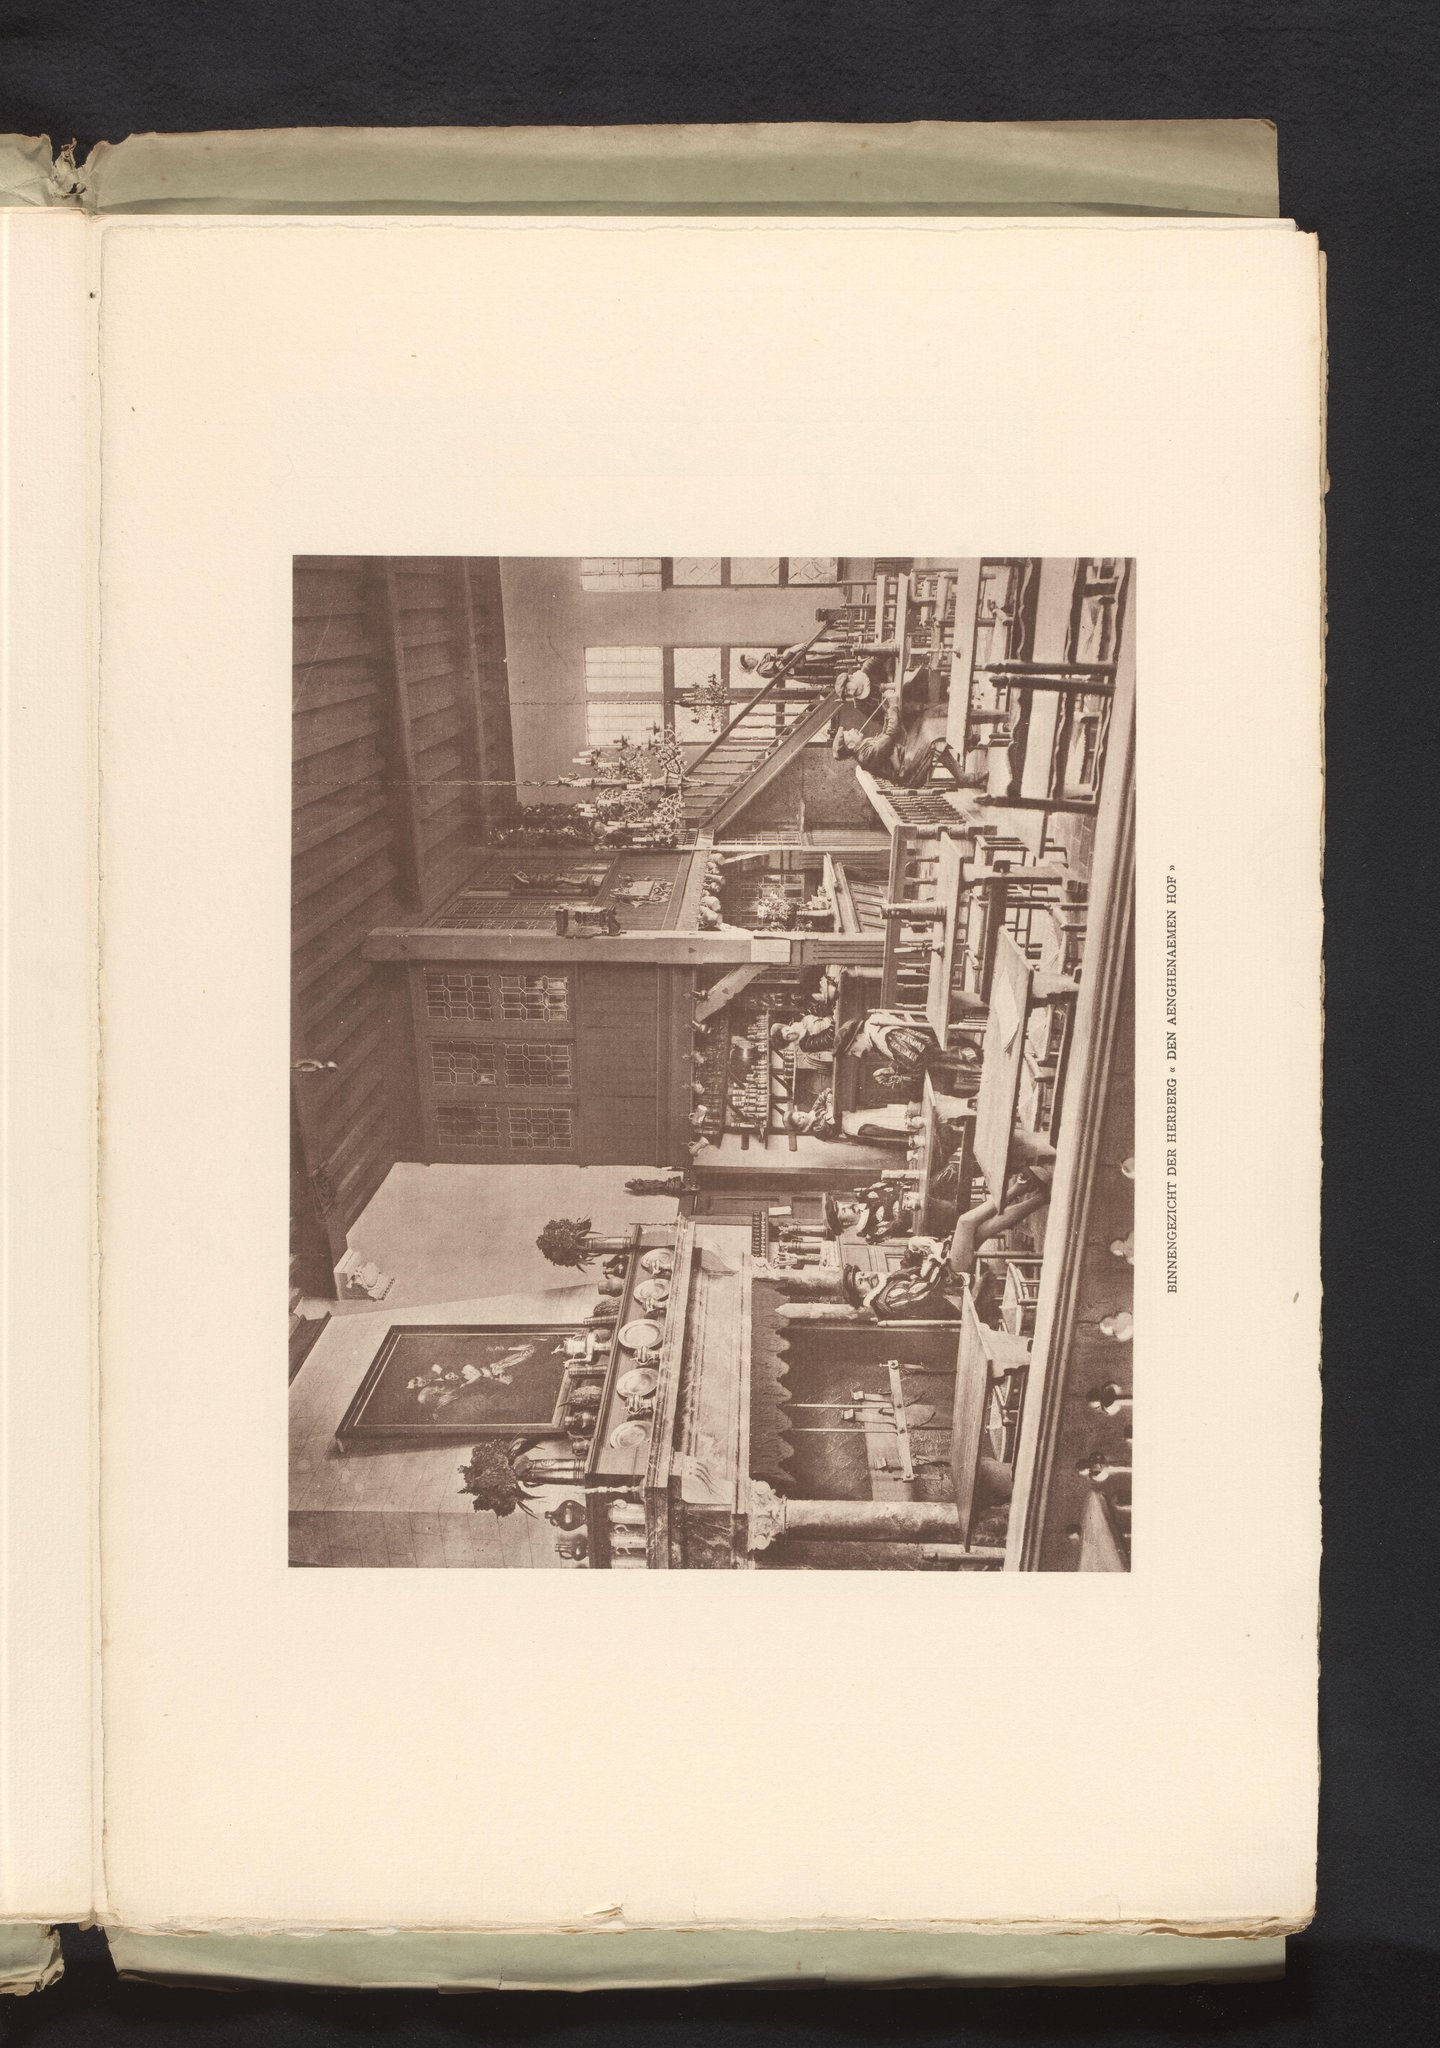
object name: photomechanical print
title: Binnengezicht der herberg <<Den Aenghenaemen Hof>>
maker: Anonymous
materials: paper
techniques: photograph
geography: antwerp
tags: world fair, world exhibition, inn, coffee-house, public house, etc., antwerp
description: Prent op los blad tussen pagina 30 en 31.